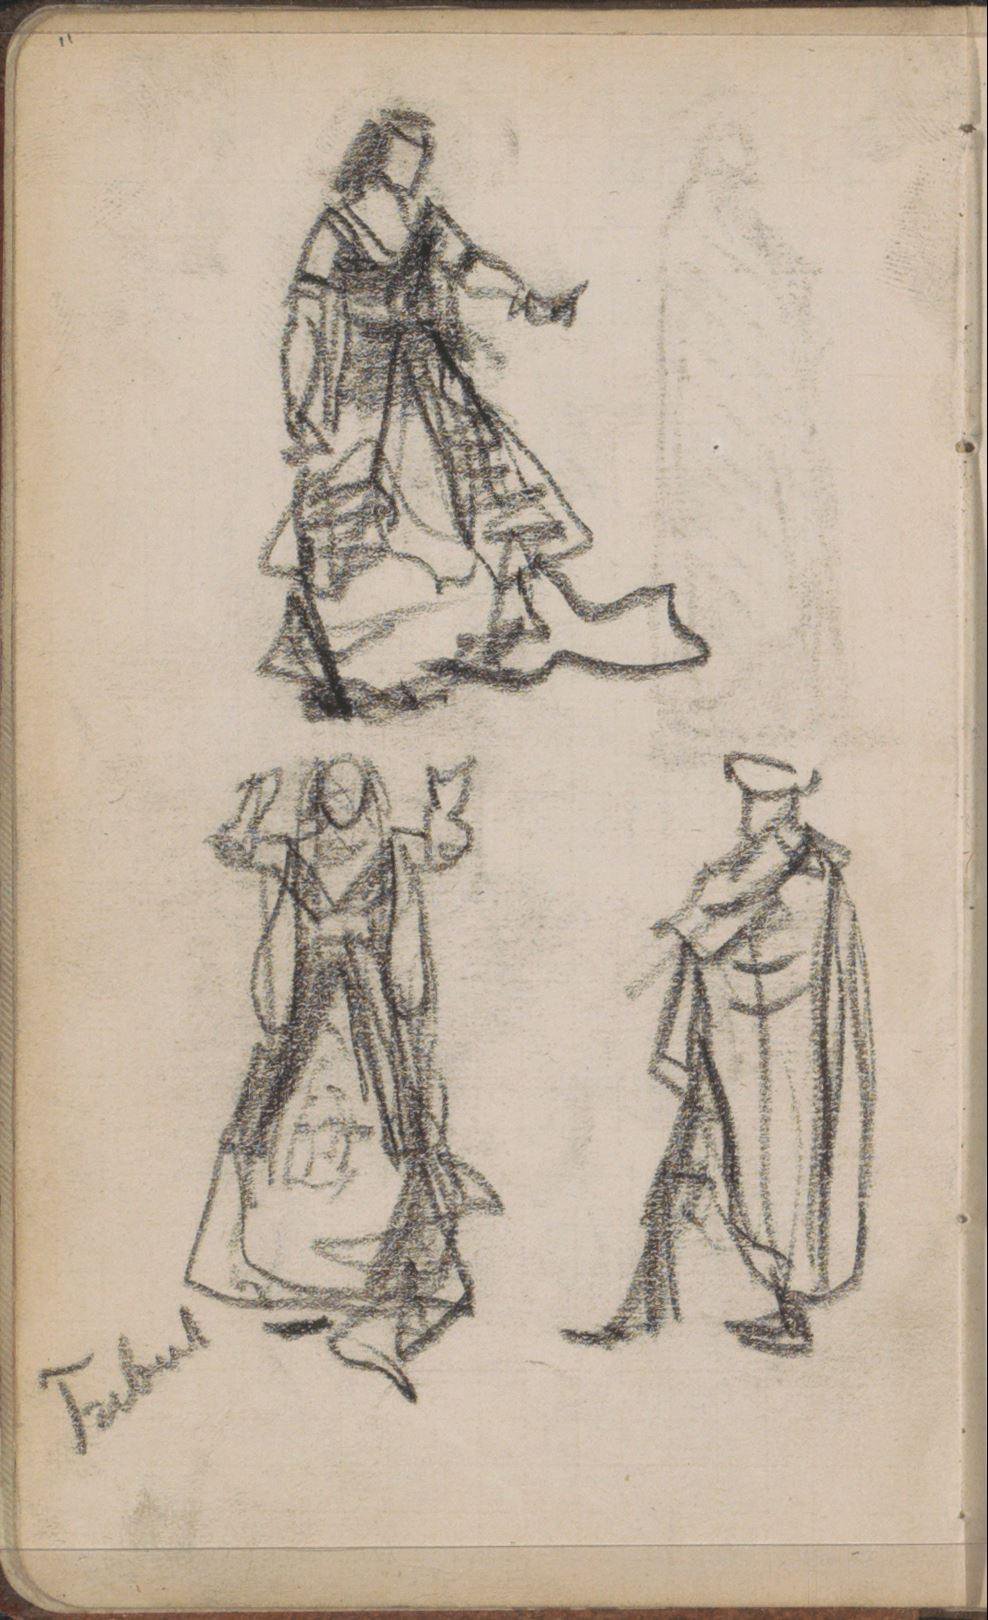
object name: sketchbook leaf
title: Figuren in historisch kostuum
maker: marius bauer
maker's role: draughtsman, print maker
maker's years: 1867-1932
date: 1879-1885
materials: chalk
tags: standing figure, adult woman, adult man, historical costume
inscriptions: annotation: ‘Tribut’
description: Mogelijk kostuums voor een theaterstuk. Pagina 11 uit een schetsboek met 58 bladen.